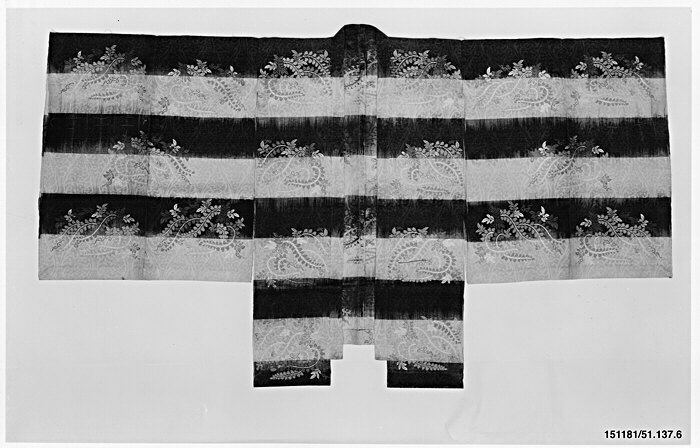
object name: noh coat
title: Noh Costume (Chōken) with Wisteria, Waves, and Purple Bands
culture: japanese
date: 1801-1850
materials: textile, metal thread, silk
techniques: brocade, weave